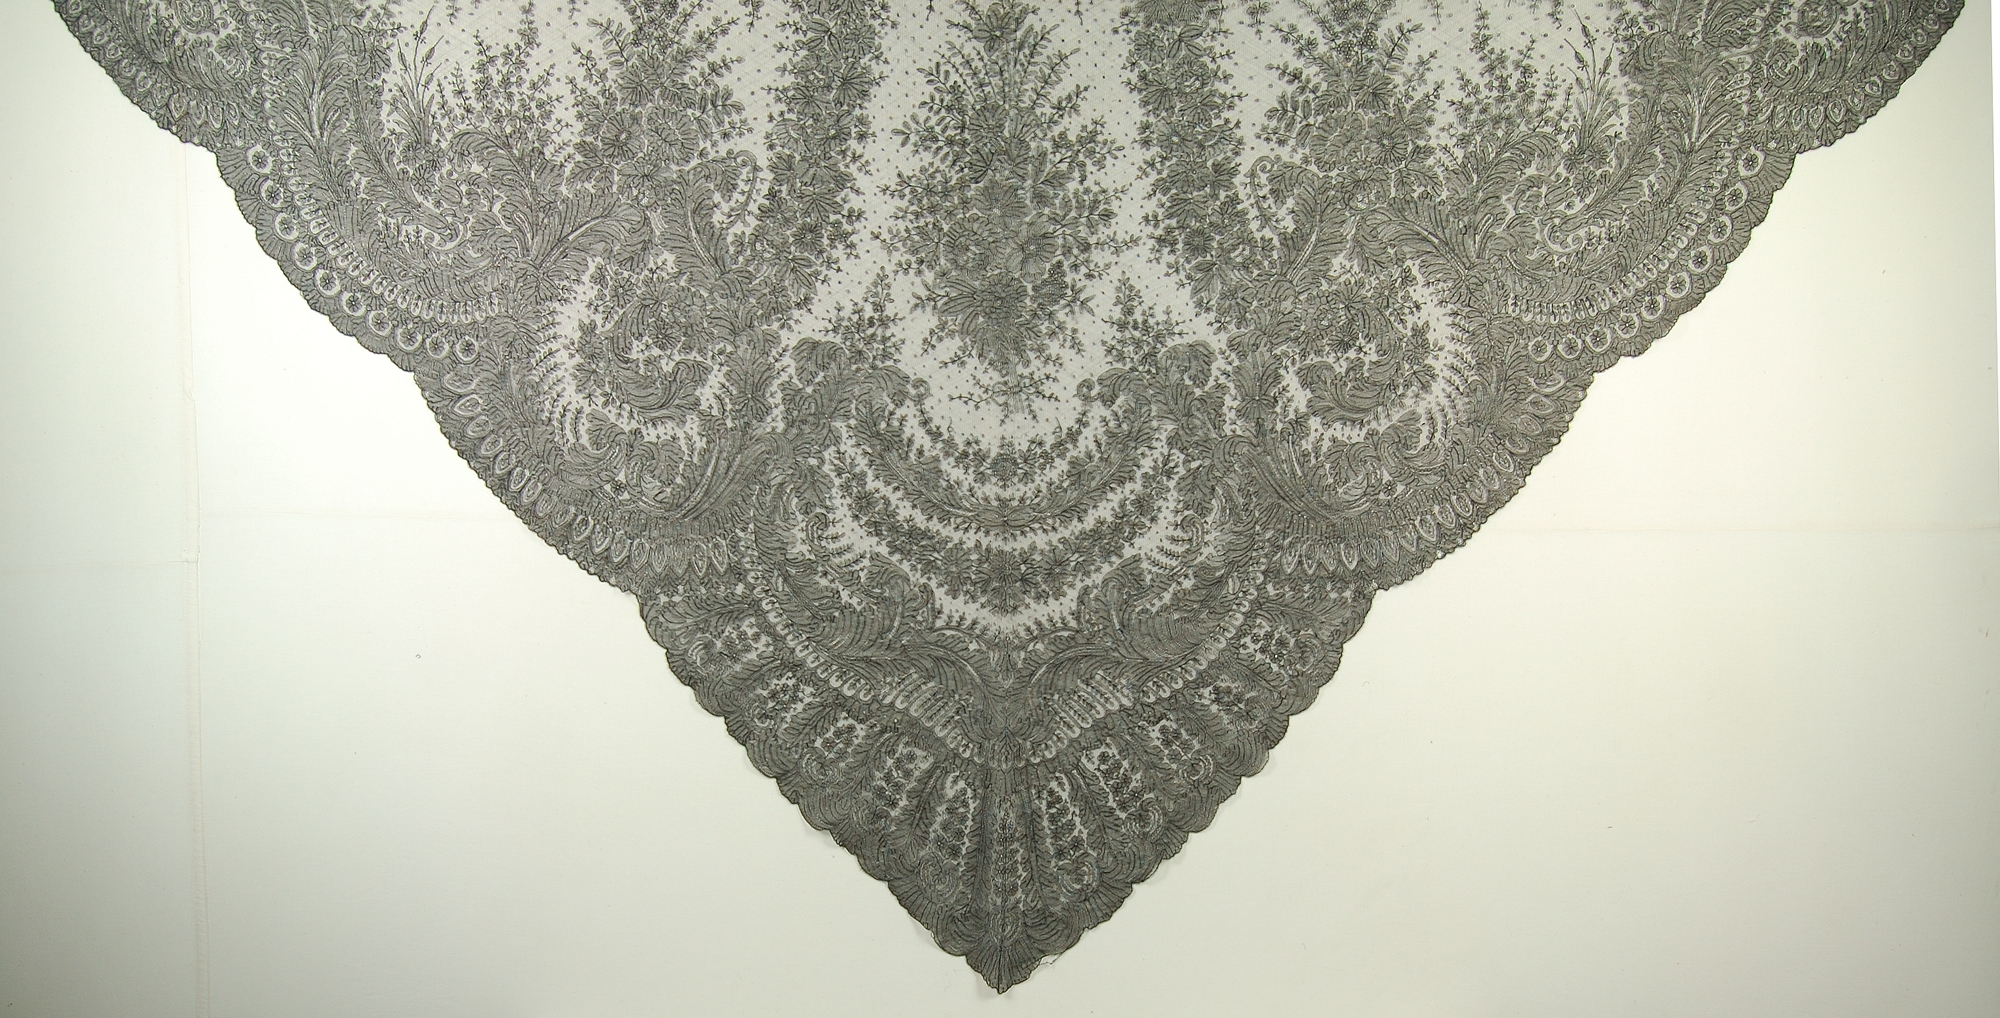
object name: shawl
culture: french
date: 1860-1870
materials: silk